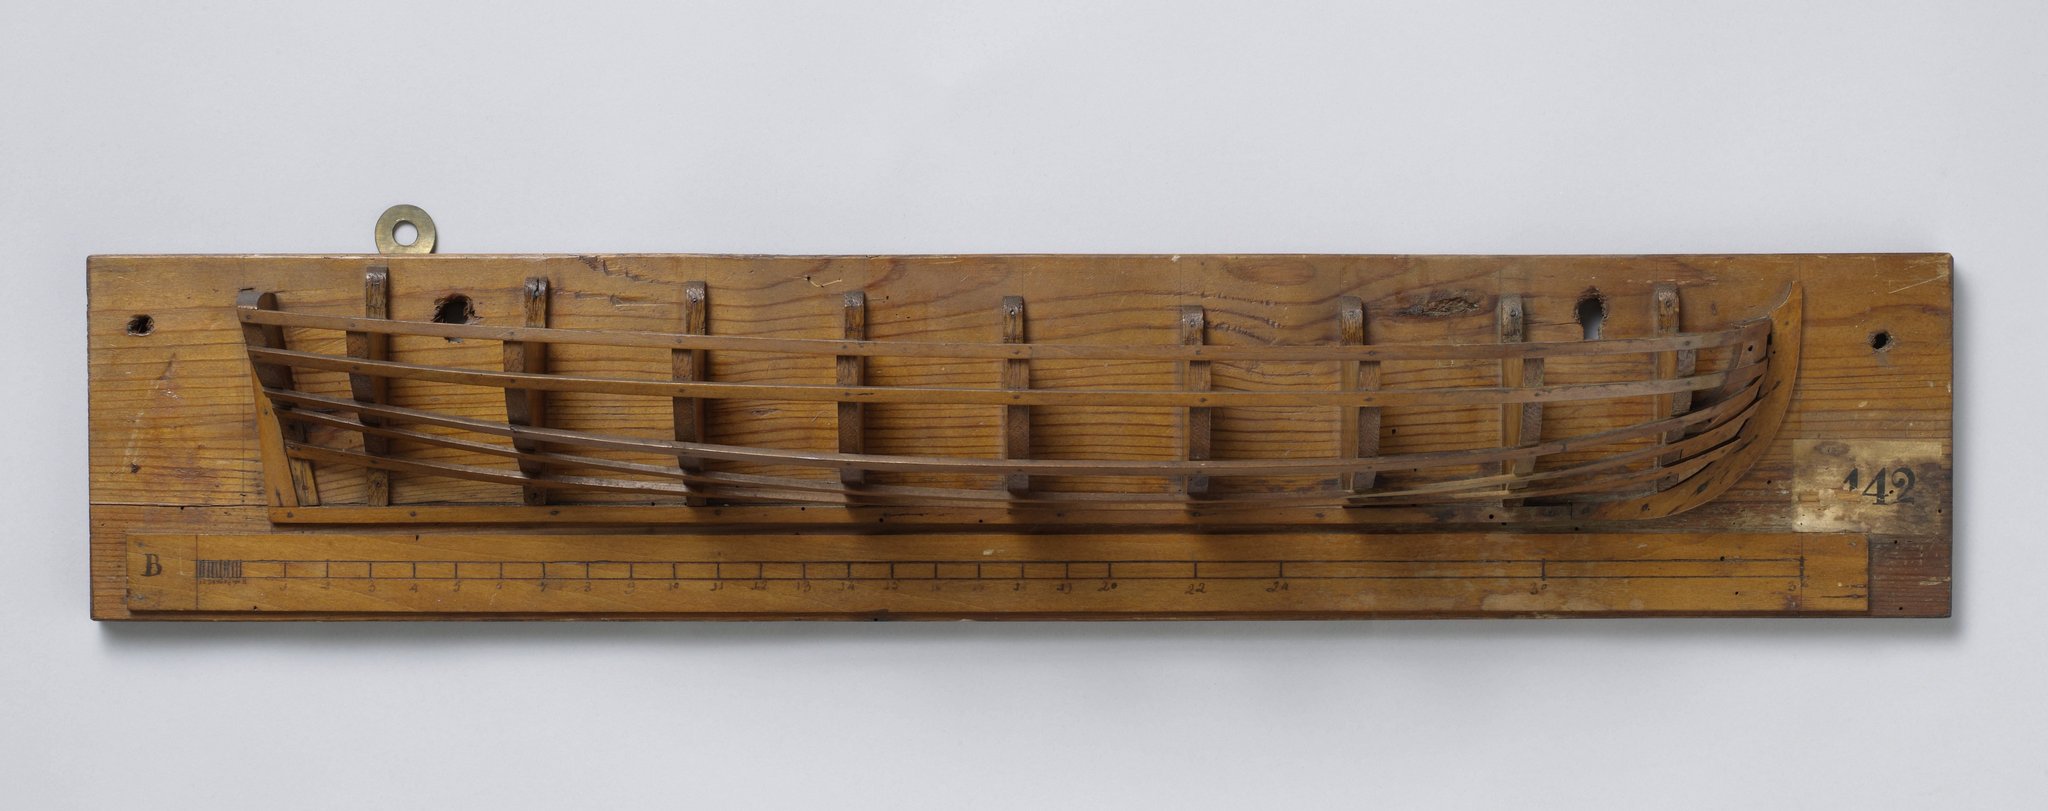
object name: builder's model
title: Half Model of a Launch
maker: Anonymous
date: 1780-1820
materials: wood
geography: netherlands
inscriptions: inscription, on the scale: ‘B’, label, bottom right: ‘442’ former inventory label, scale, bottom centre: wooden scale in Amsterdam feet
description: Mallenmodel (stuurboord) van een sloep. Platte spiegel. De zeeg loopt op naar beide uiteinden. Gepiekt rondspant. Schaal ca. 1:20 (schaal op model). Volgens de schaal is deze jol 36 Amsterdamse voeten lang. Dit model is identiek aan NG-MC-444.